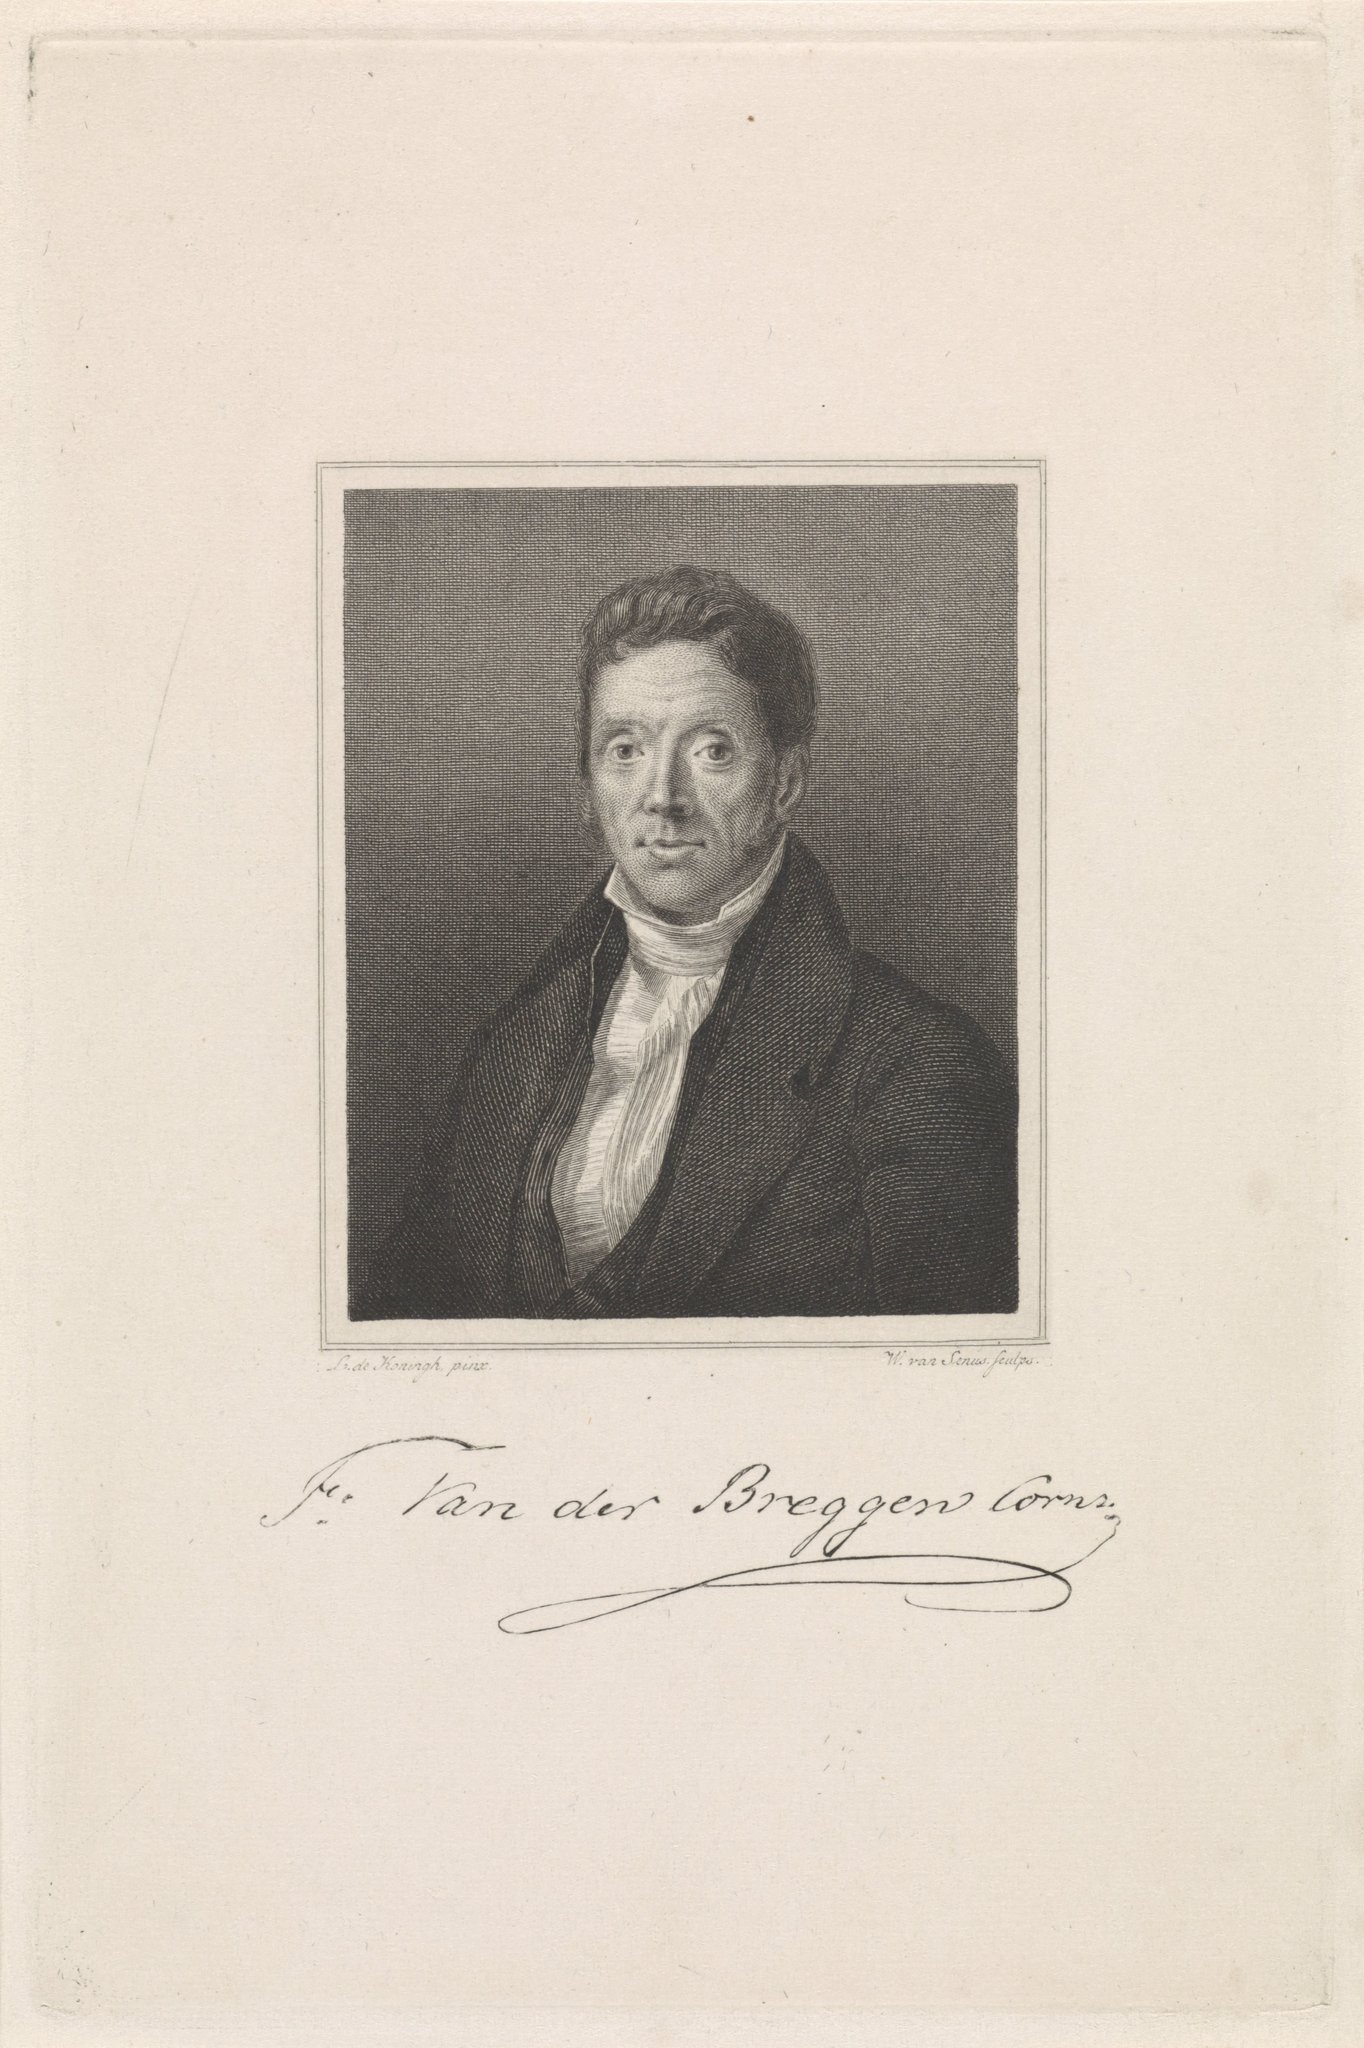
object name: print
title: Portret van Frans van der Breggen Cornzn.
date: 1817-1851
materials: paper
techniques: engraving, etching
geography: netherlands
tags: leiden, amsterdam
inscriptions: collector's mark: Lugt 2228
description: Portret van Frans van der Breggen Cornzn., hoogleraar geneeskunde.